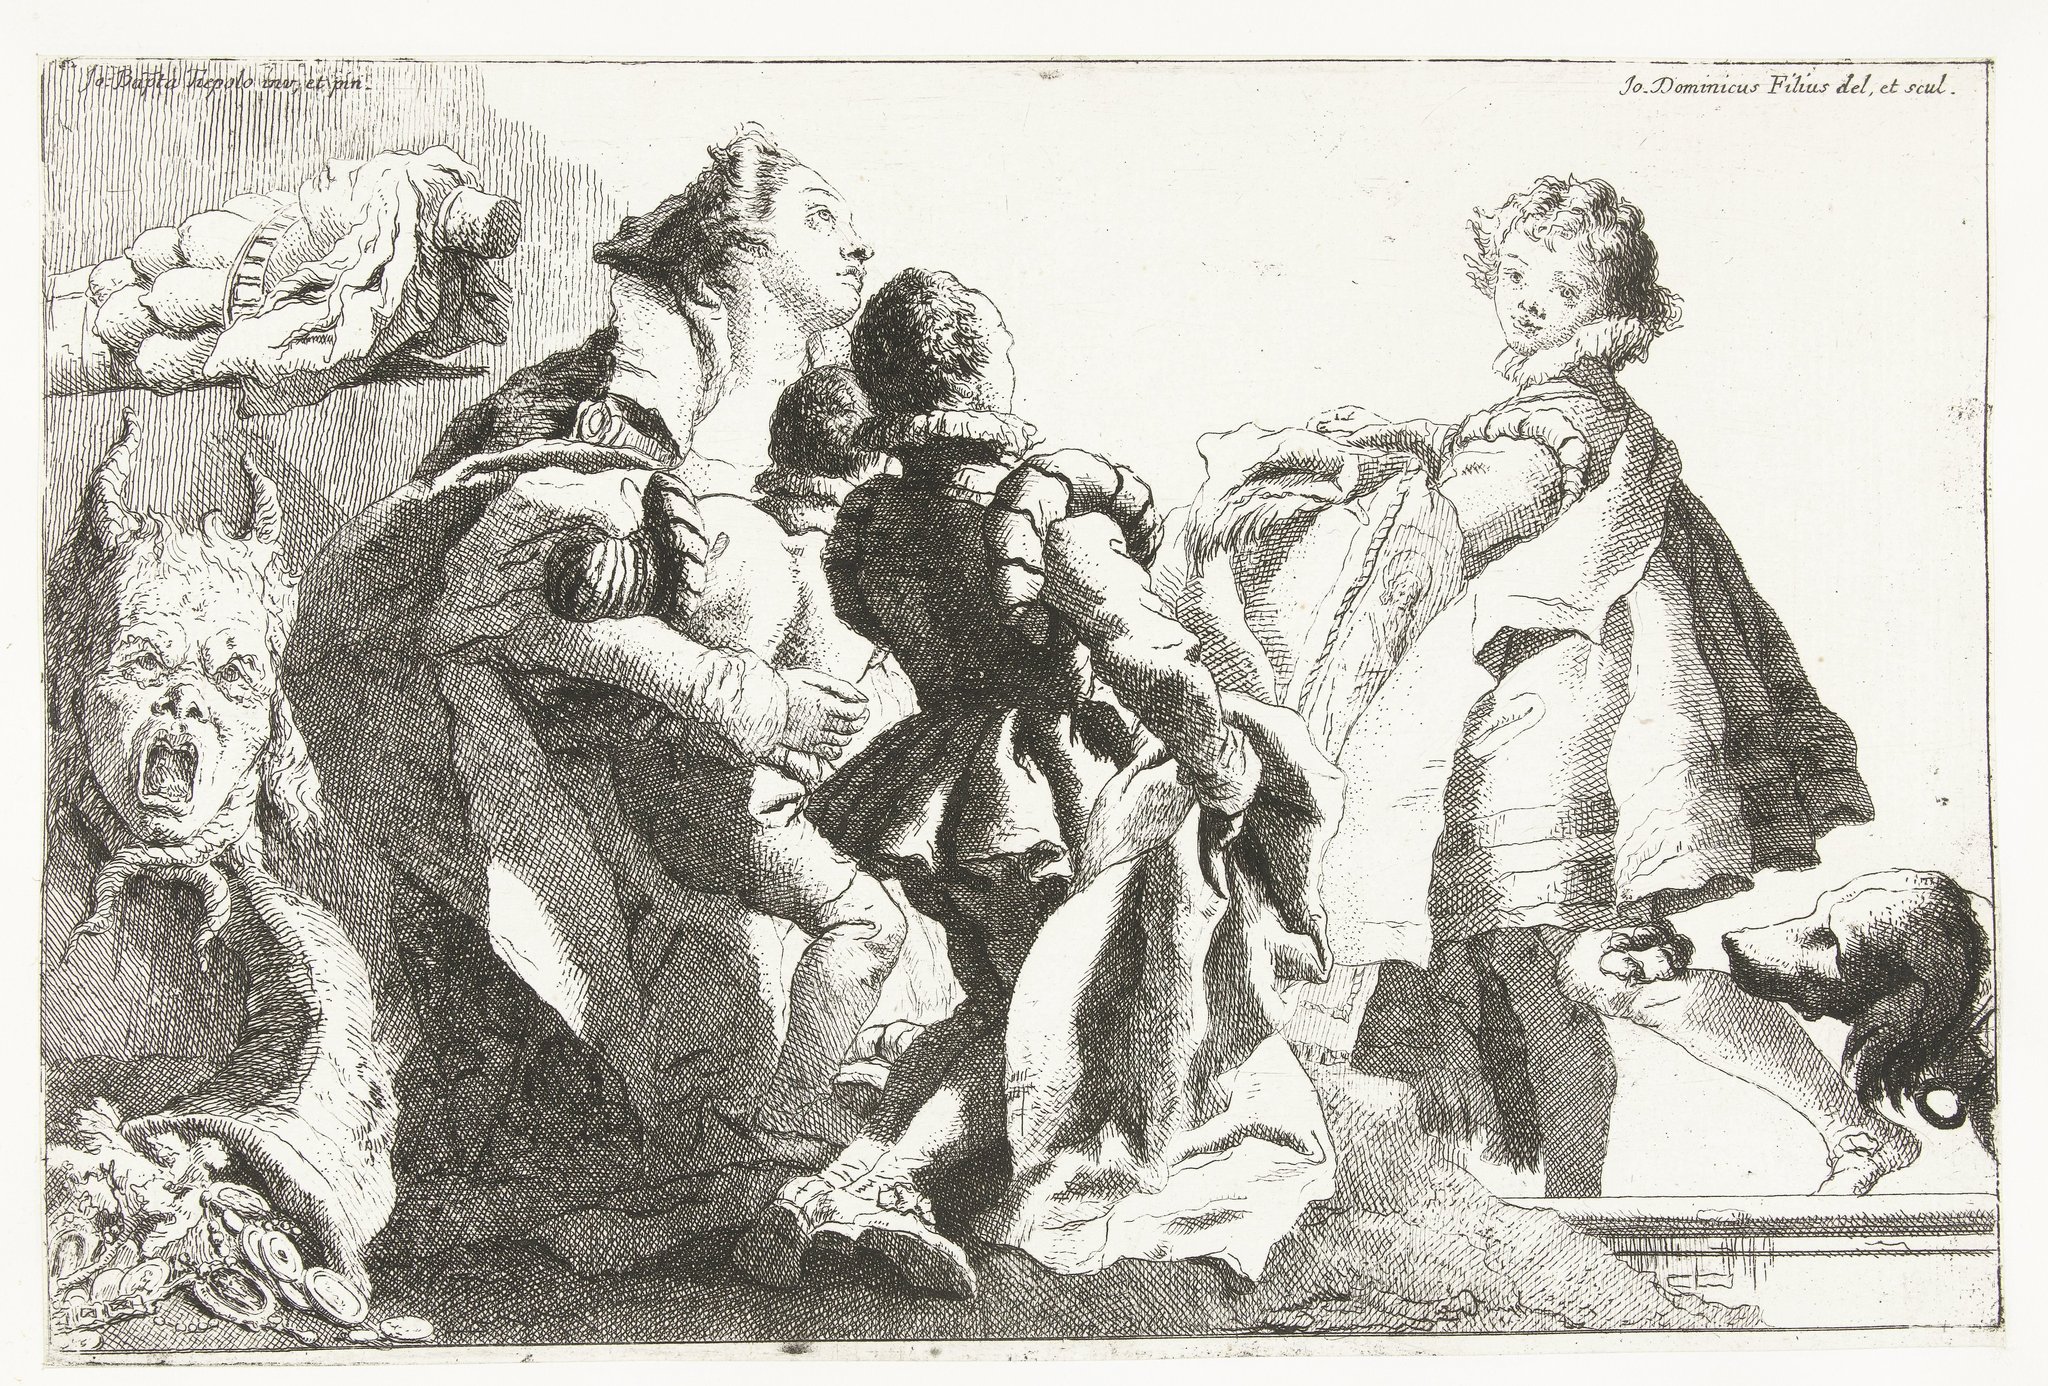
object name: print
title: Vrouw met drie kinderen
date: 1751-1755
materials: paper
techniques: etching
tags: child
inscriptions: collector's mark: Lugt 2228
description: Prent gebaseerd op verschillende details uit fresco's van Giovanni Battista Tiepolo in Würzburg (Rizzi 1971, p. 326).